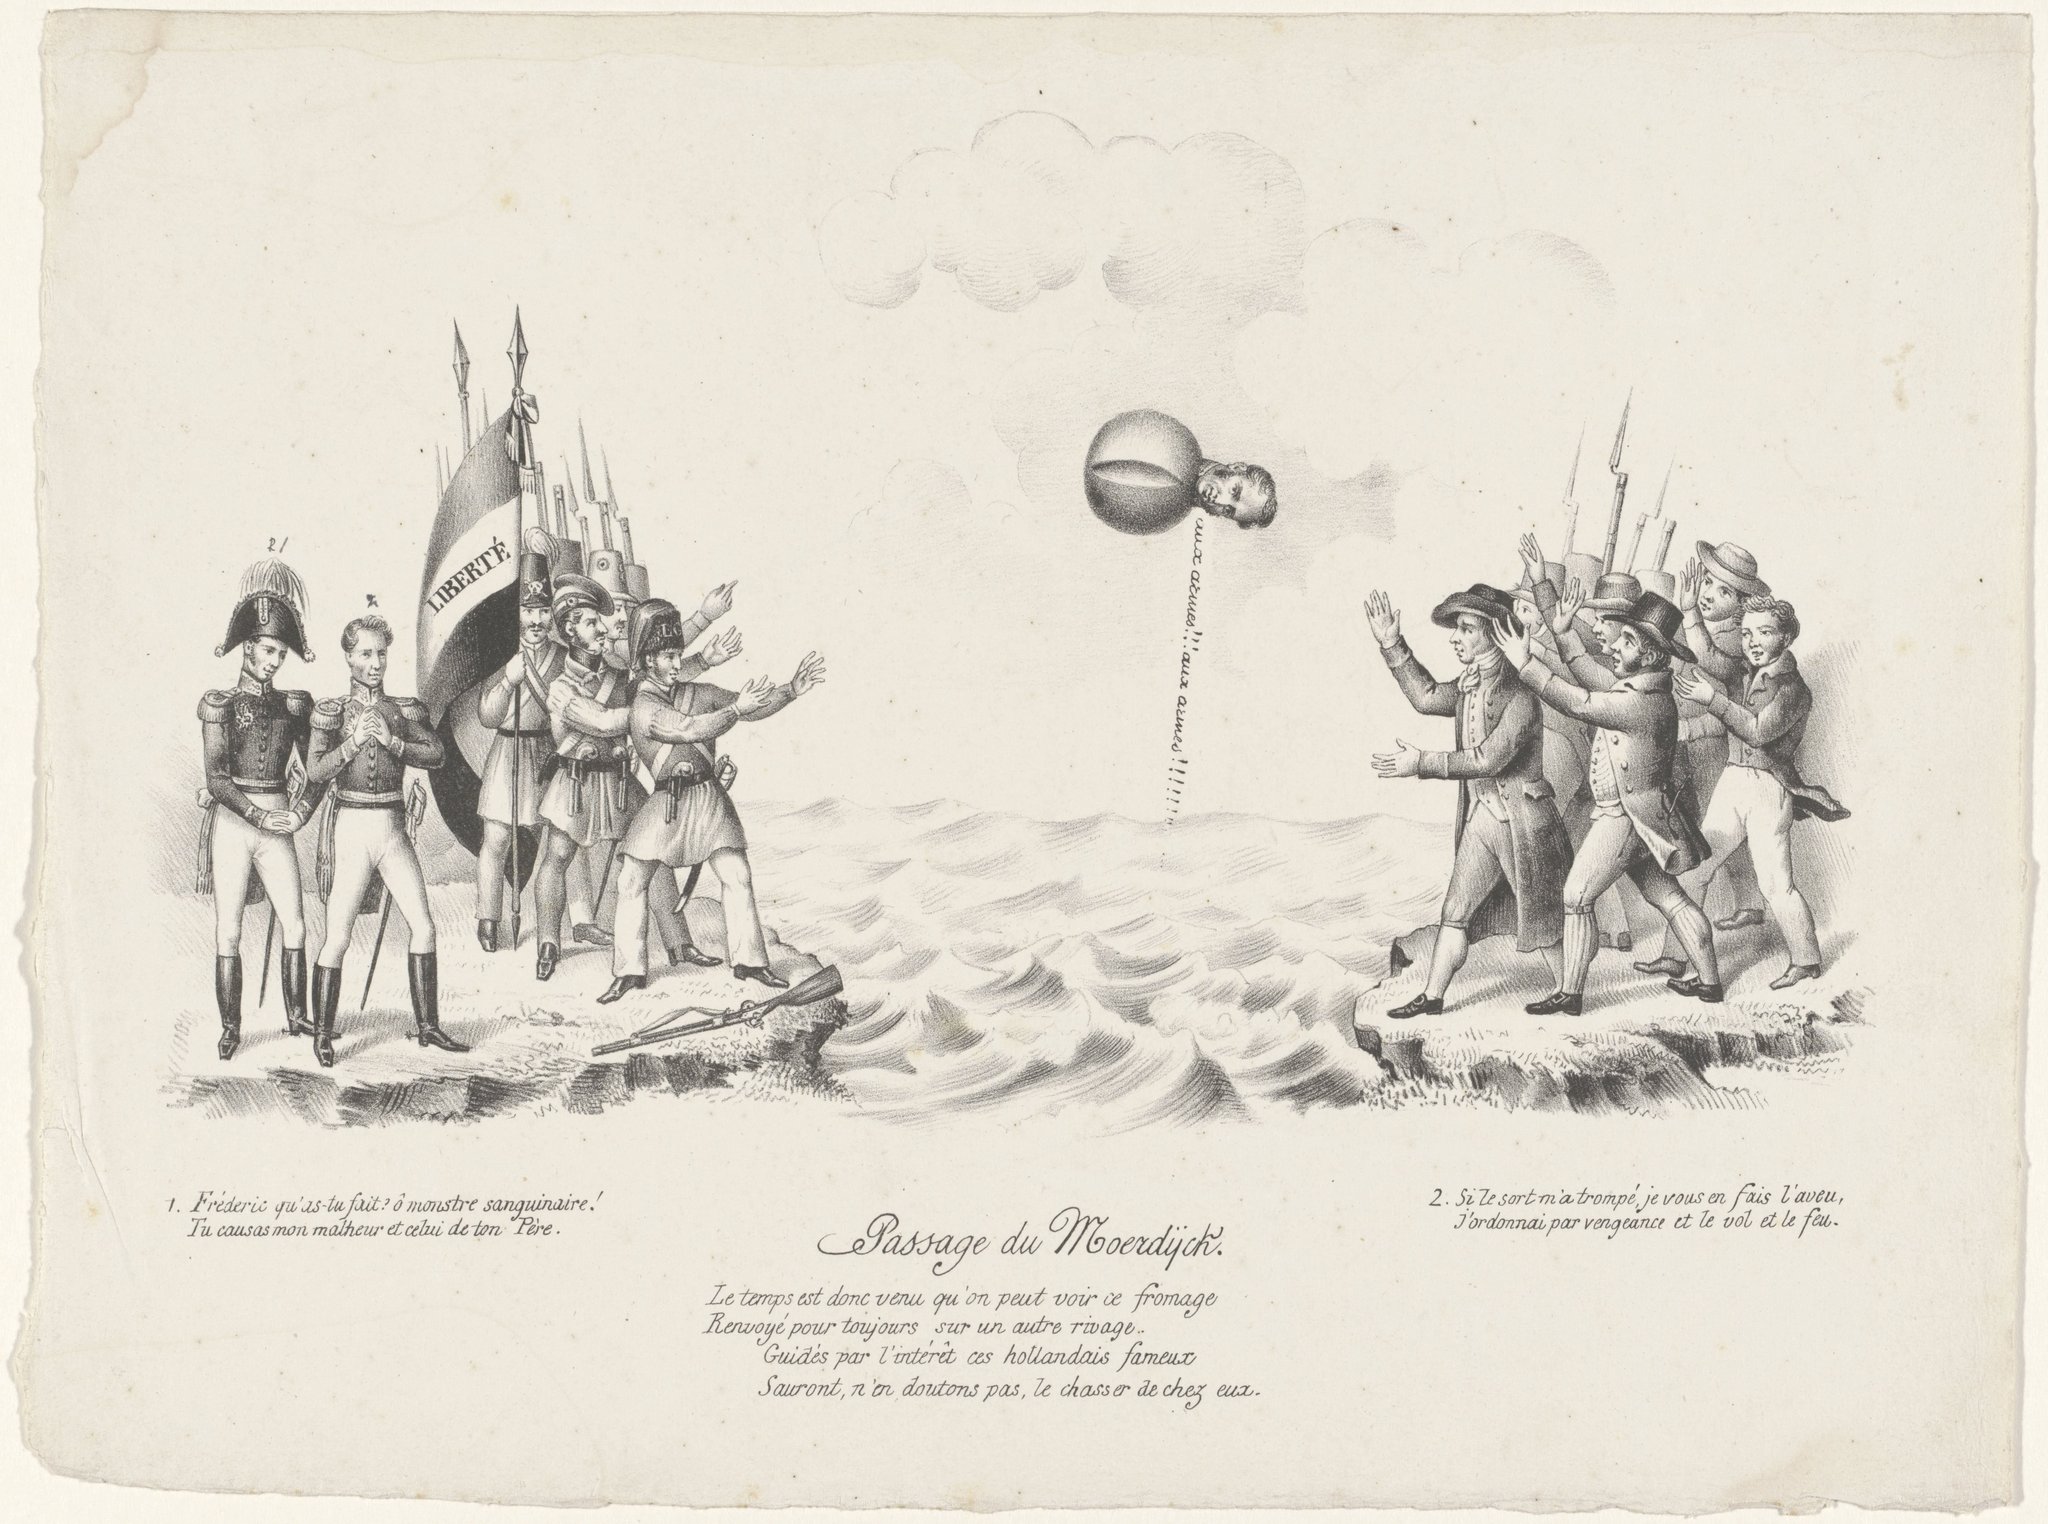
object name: print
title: Passage du Moerdijck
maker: Anonymous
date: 1830-1831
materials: paper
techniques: lithograph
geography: belgium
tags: berlin, william i of the netherlands, william ii of the netherlands, frederik (prins der nederlanden), throwing something, throwing games, revolution, revolt, cheese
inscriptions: collector's mark: Lugt 2228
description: Spotprent op de vervallenverklaring van het Huis van Oranje van de Belgische troon door het Belgische Congres, 23 november 1830. De Belgische opstandelingen gooien een ronde kaas getooid met het hoofd van koning Willem I over de Moerdijk terug naar Nederland waar een groep Nederlanders klaar staat deze op te vangen. Aan de Belgische zijde staan nog de kroonprins en prins Frederik. Met onderschriften 1-2 en centraal een vierregelig vers.